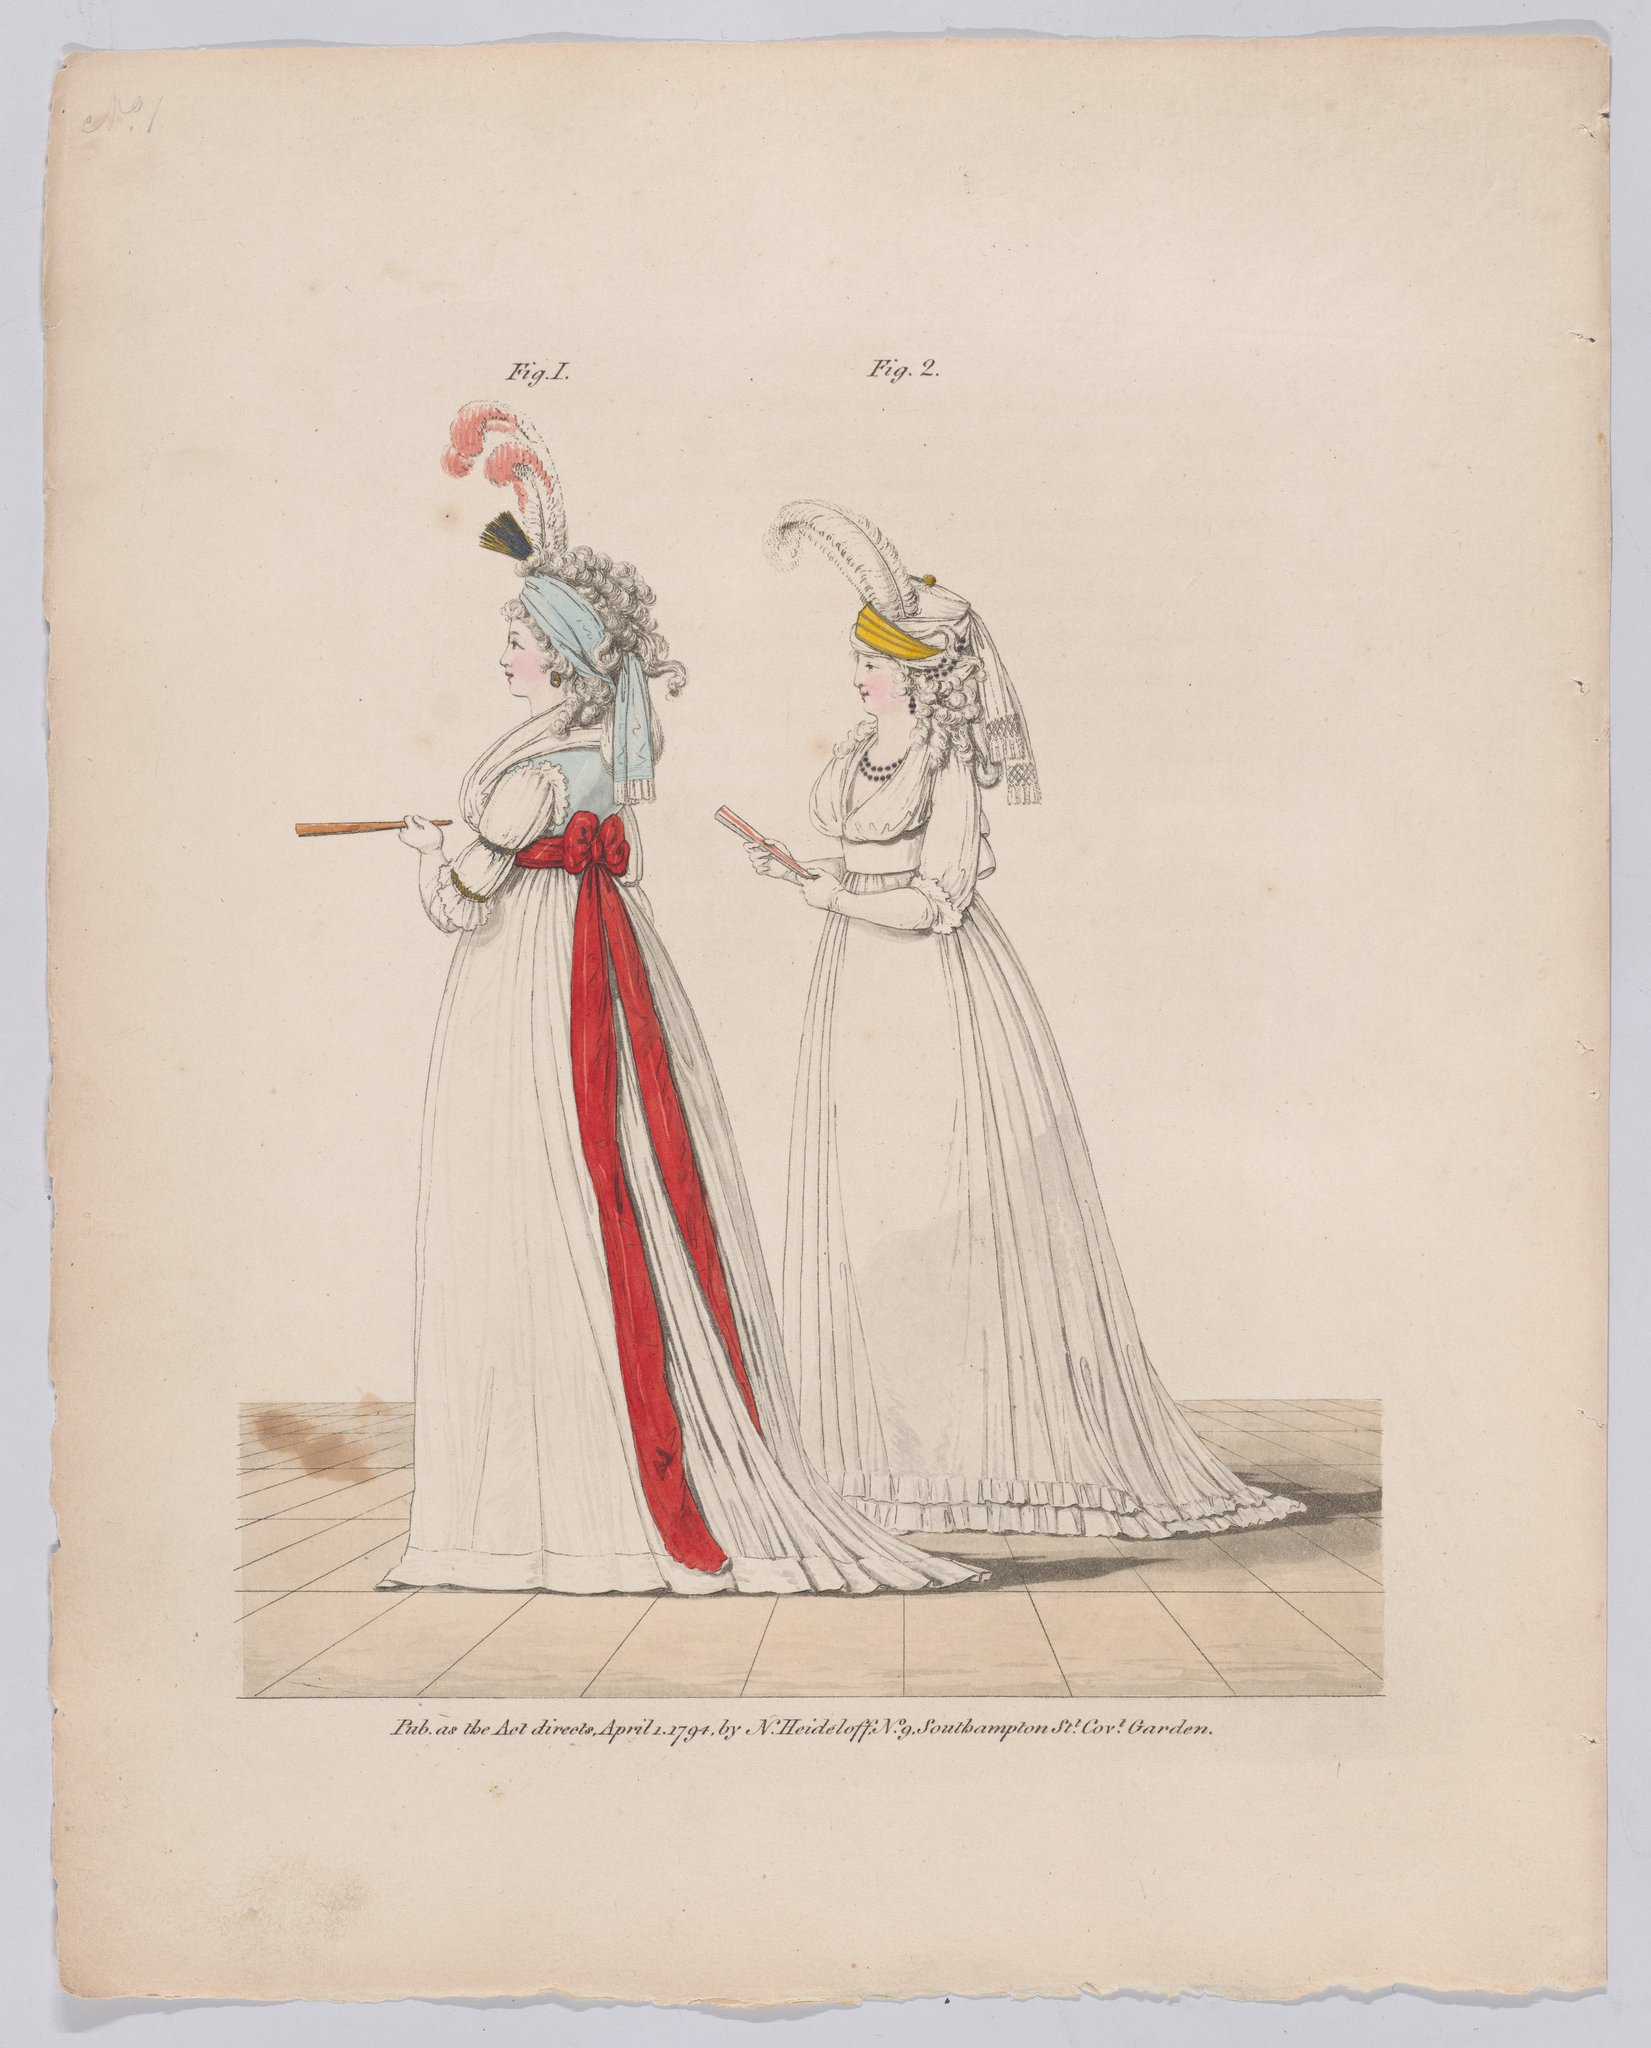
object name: book costume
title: Gallery of Fashion, vol. I: April 1, 1794- March 1, 1795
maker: nicolaus heideloff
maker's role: publisher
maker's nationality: british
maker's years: 1761-1837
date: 1794-1802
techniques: engraving, etching, hand coloring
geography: england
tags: women,fashion